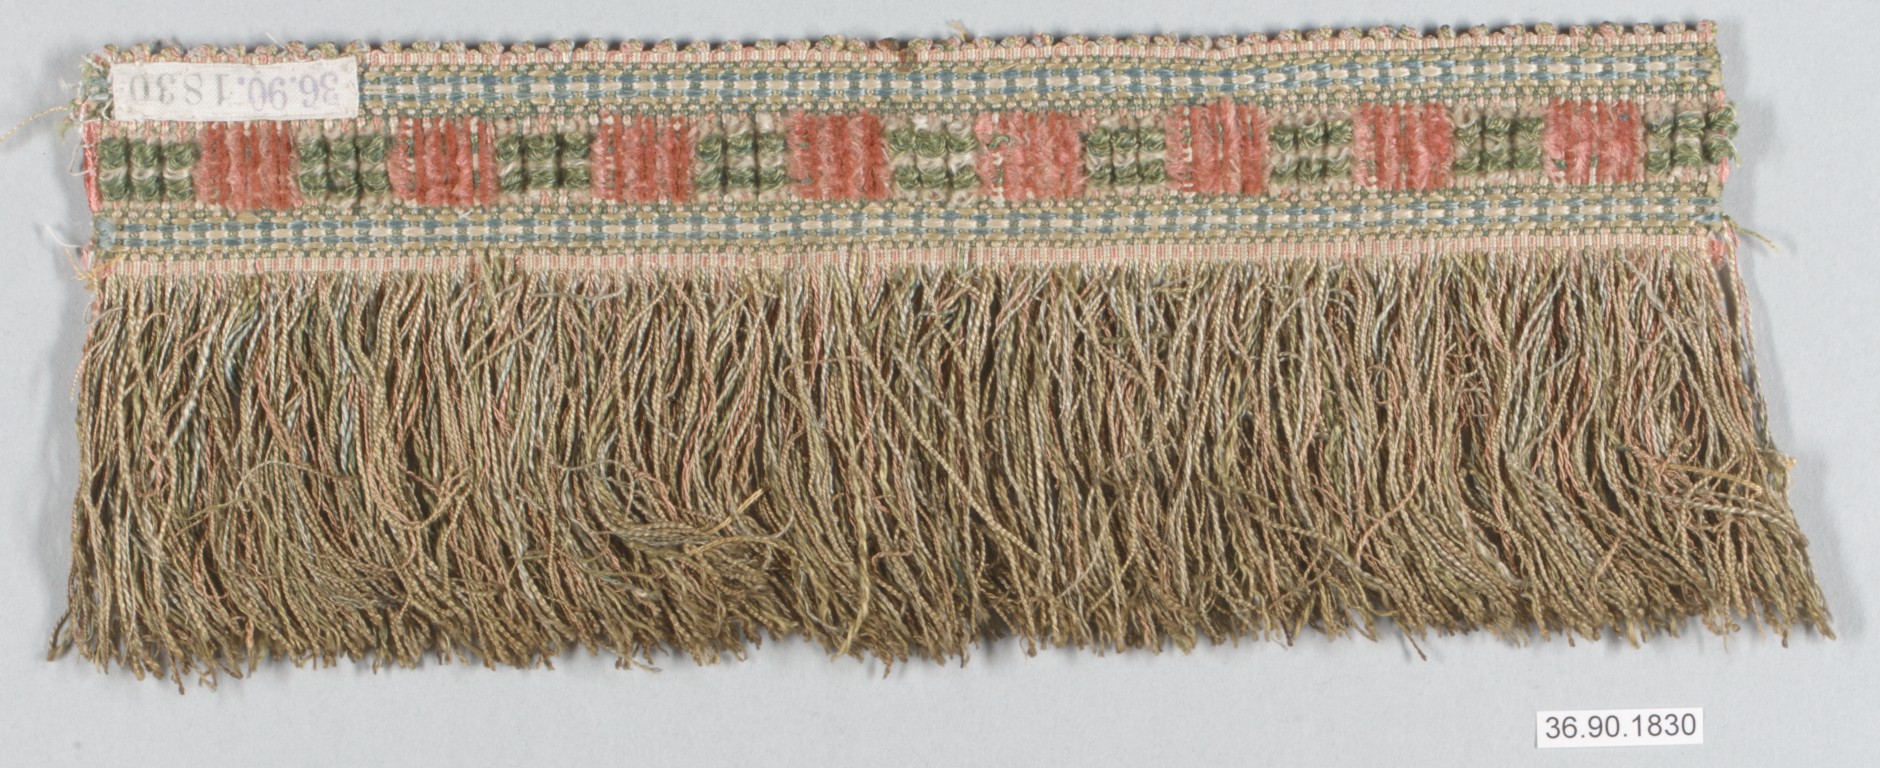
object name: fringe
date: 1767-1800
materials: silk